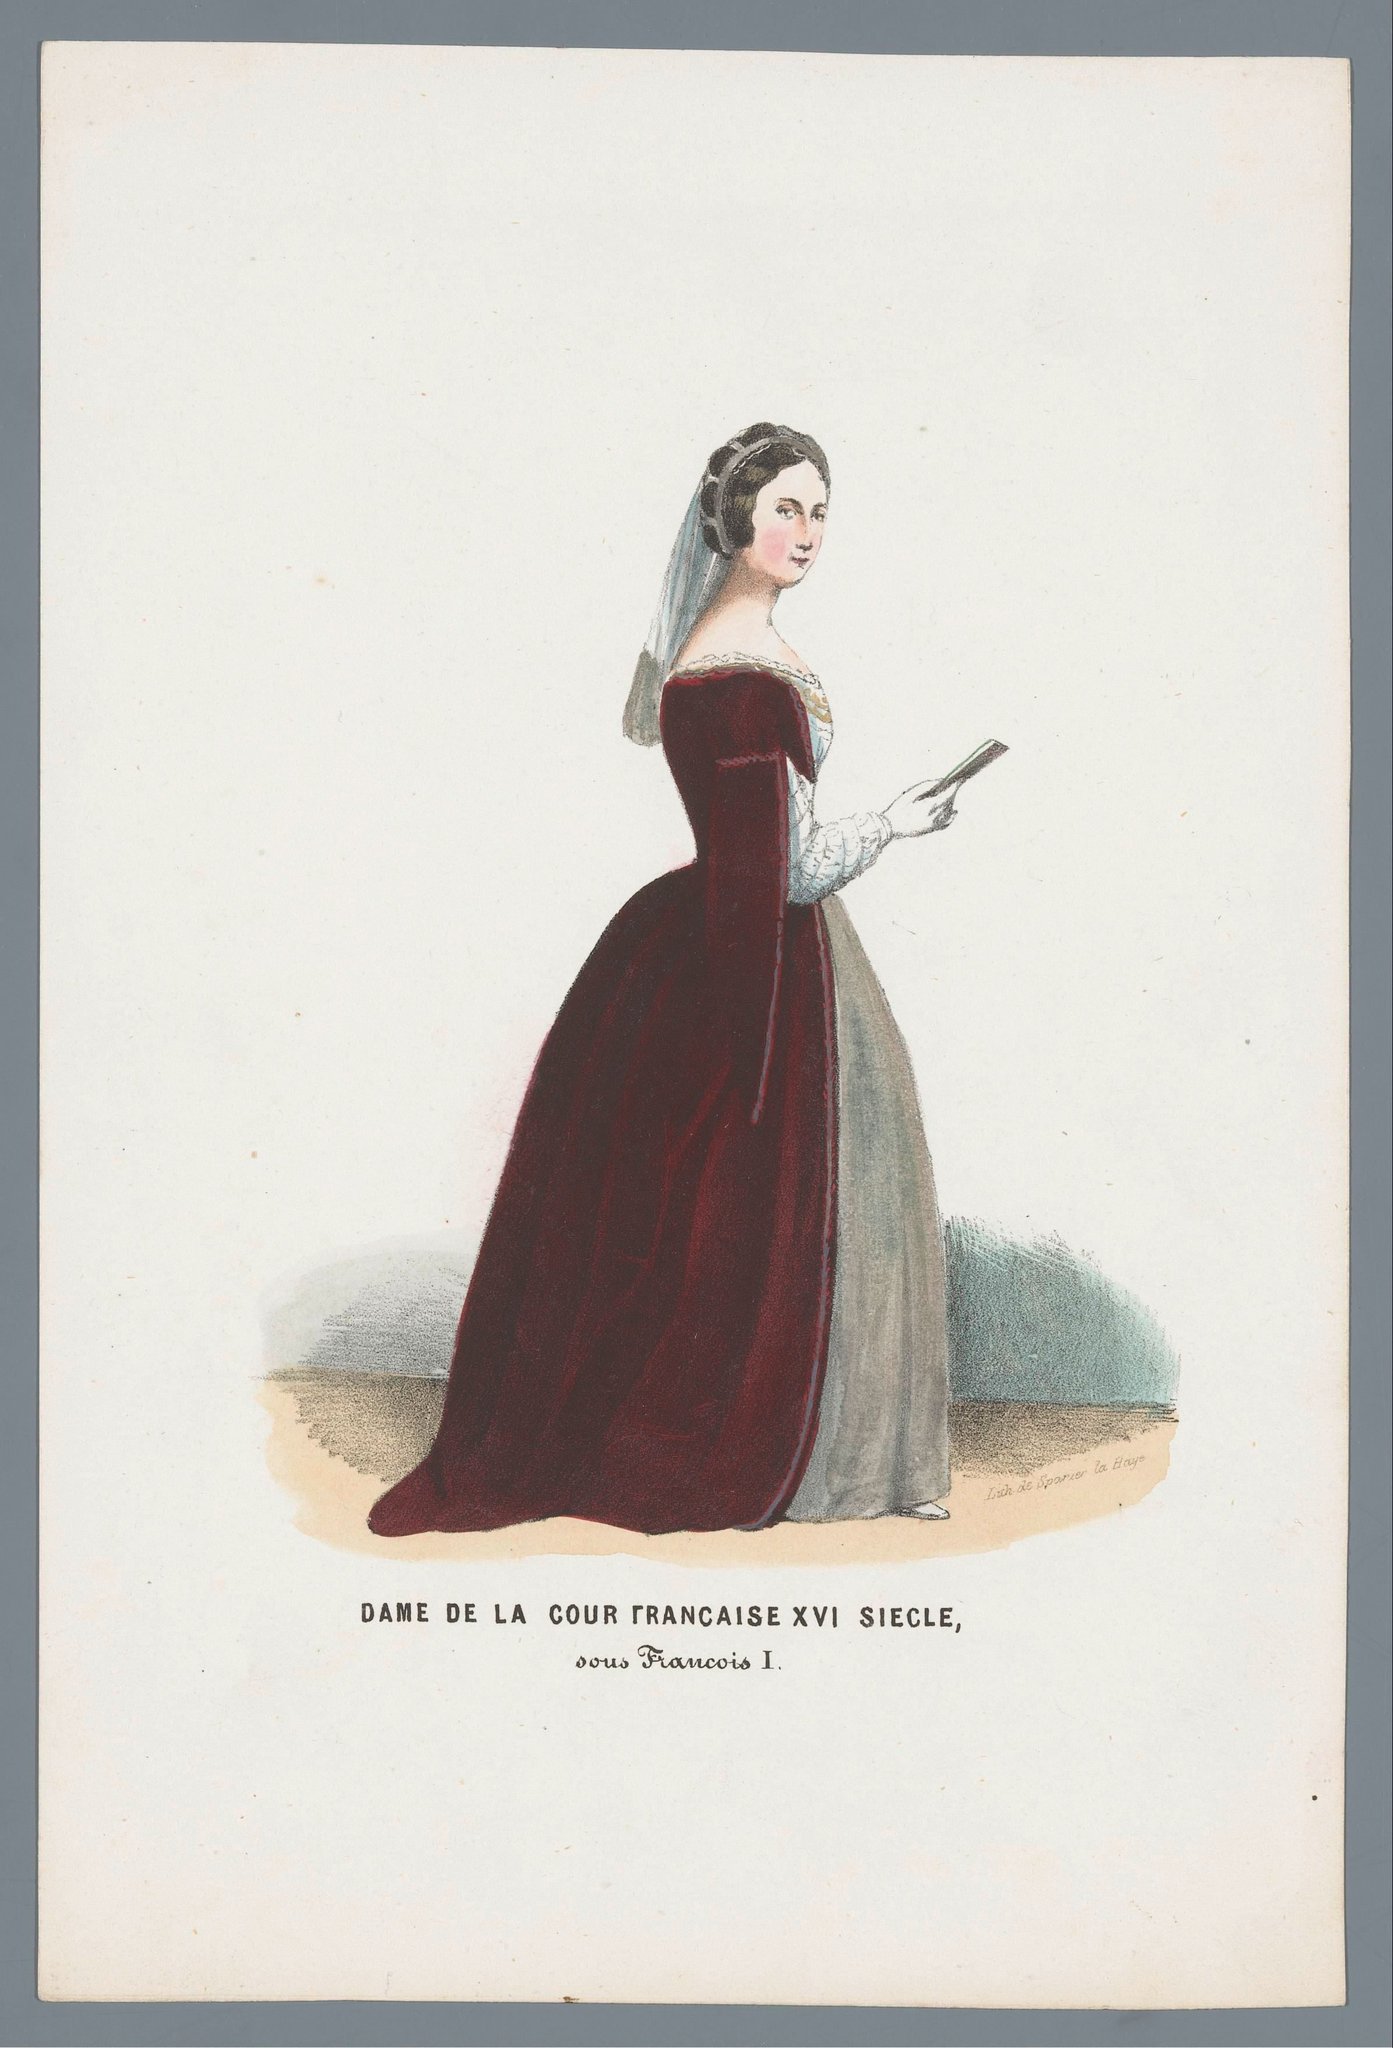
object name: costume print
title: Dame de la cour Francaise XVI Siècle, sous Francois I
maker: elias spanier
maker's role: print maker, printer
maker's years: 1821-1863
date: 1840-1850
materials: paper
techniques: hand coloring, lithograph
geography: the hague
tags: historical costume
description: Vrouw in historisch kostuum van een hofdame aan het hof van Frans I, 16e eeuw. Voorstelling toegevoegd aan het plaatwerk over het gekostumeerd bal gehouden op het paleis van de prins van Oranje (de latere koning Willem III) in Den Haag op 26 februari 1845.